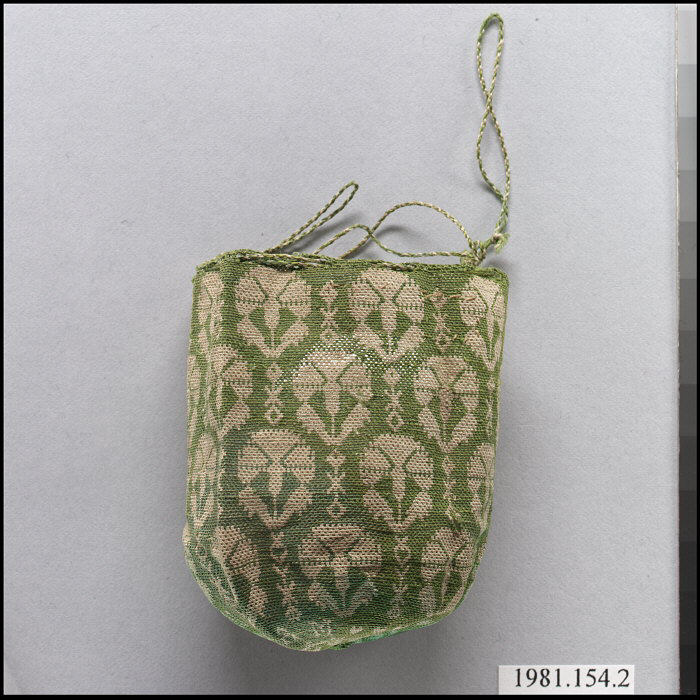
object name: purse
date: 1700